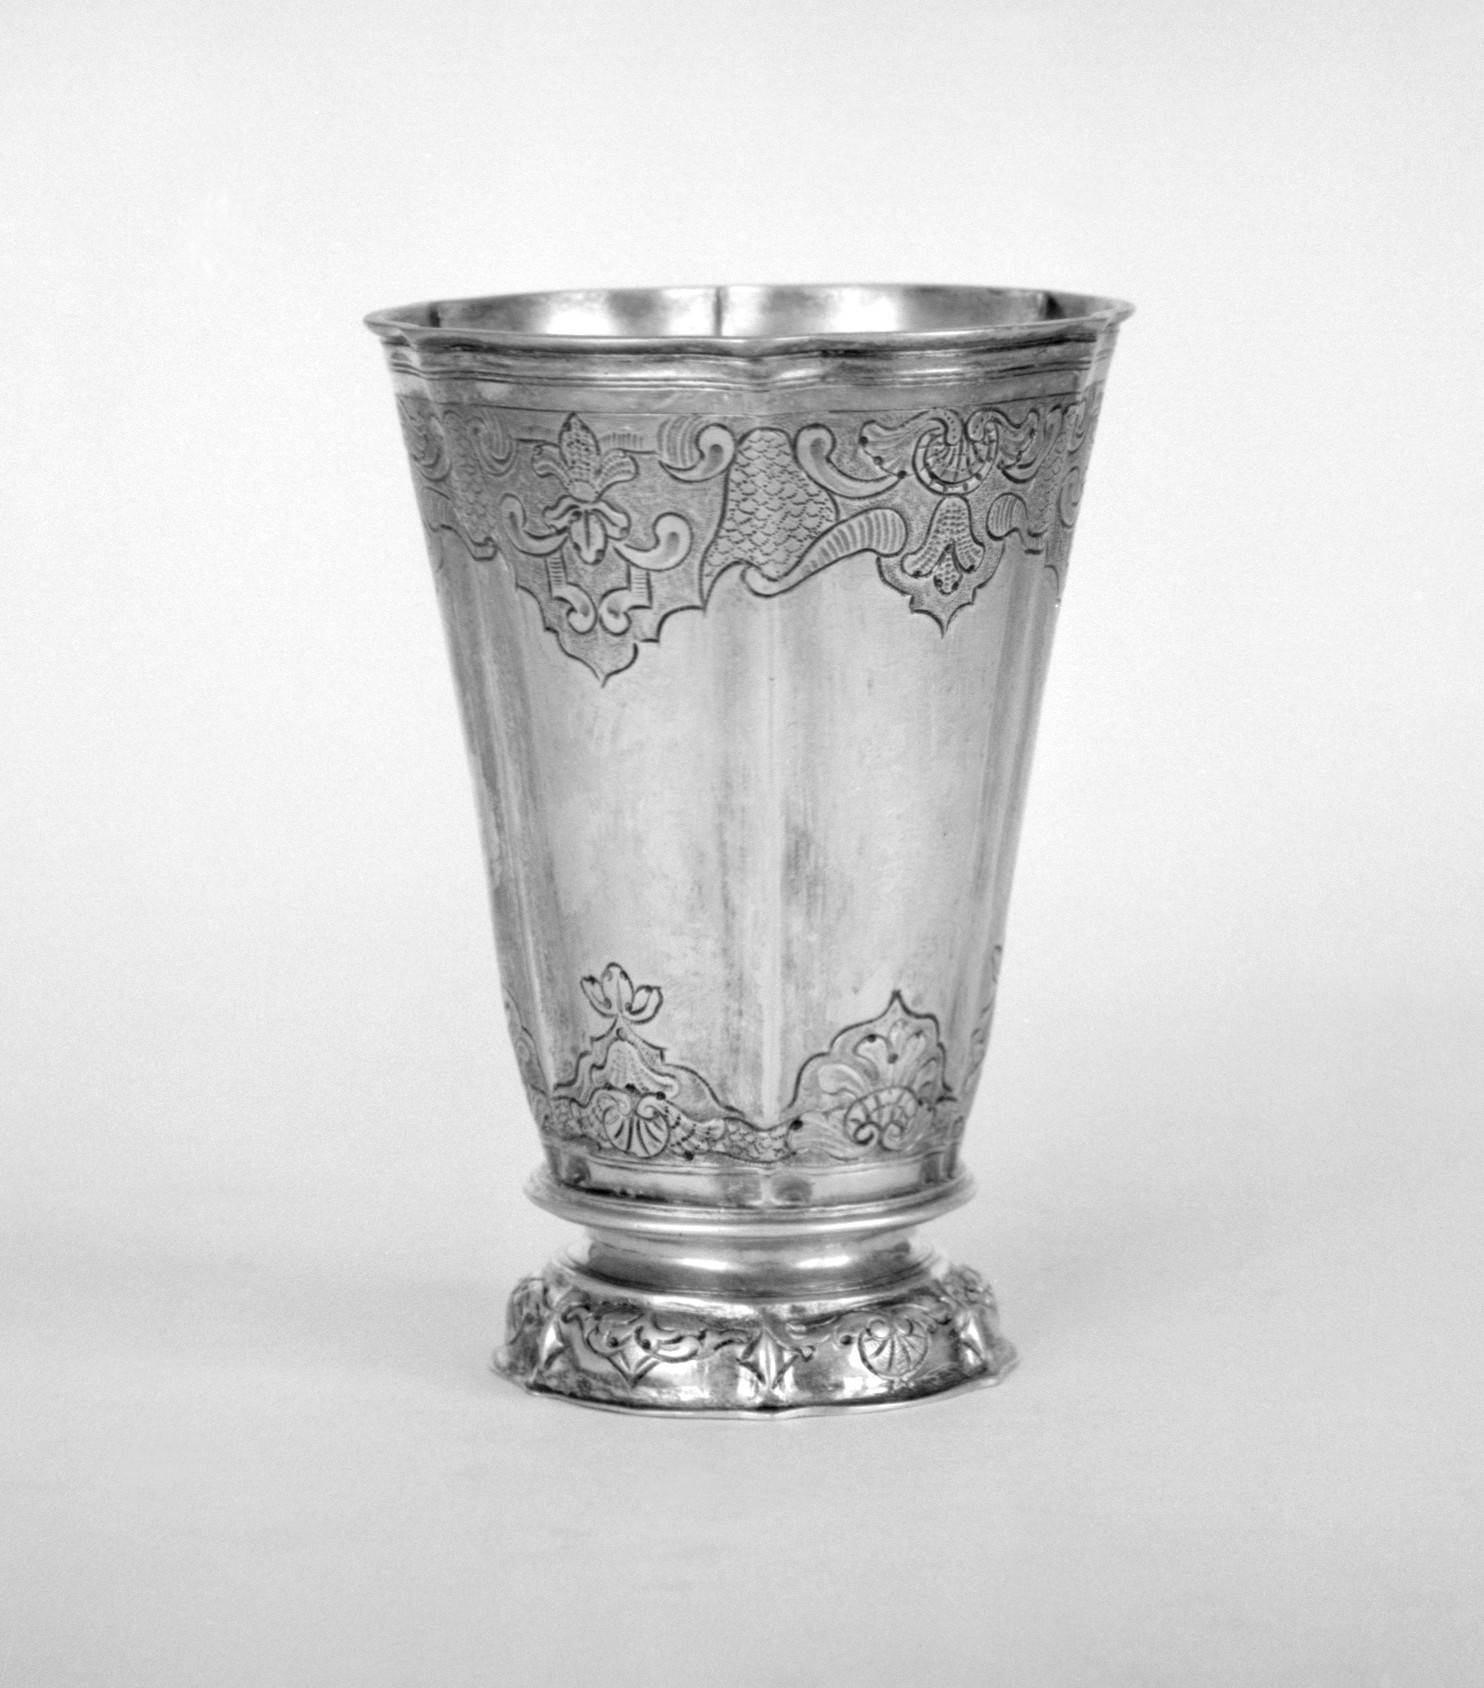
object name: beaker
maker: johann leonhard allmann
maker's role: maker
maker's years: 1697-1775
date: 1755-1757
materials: silver